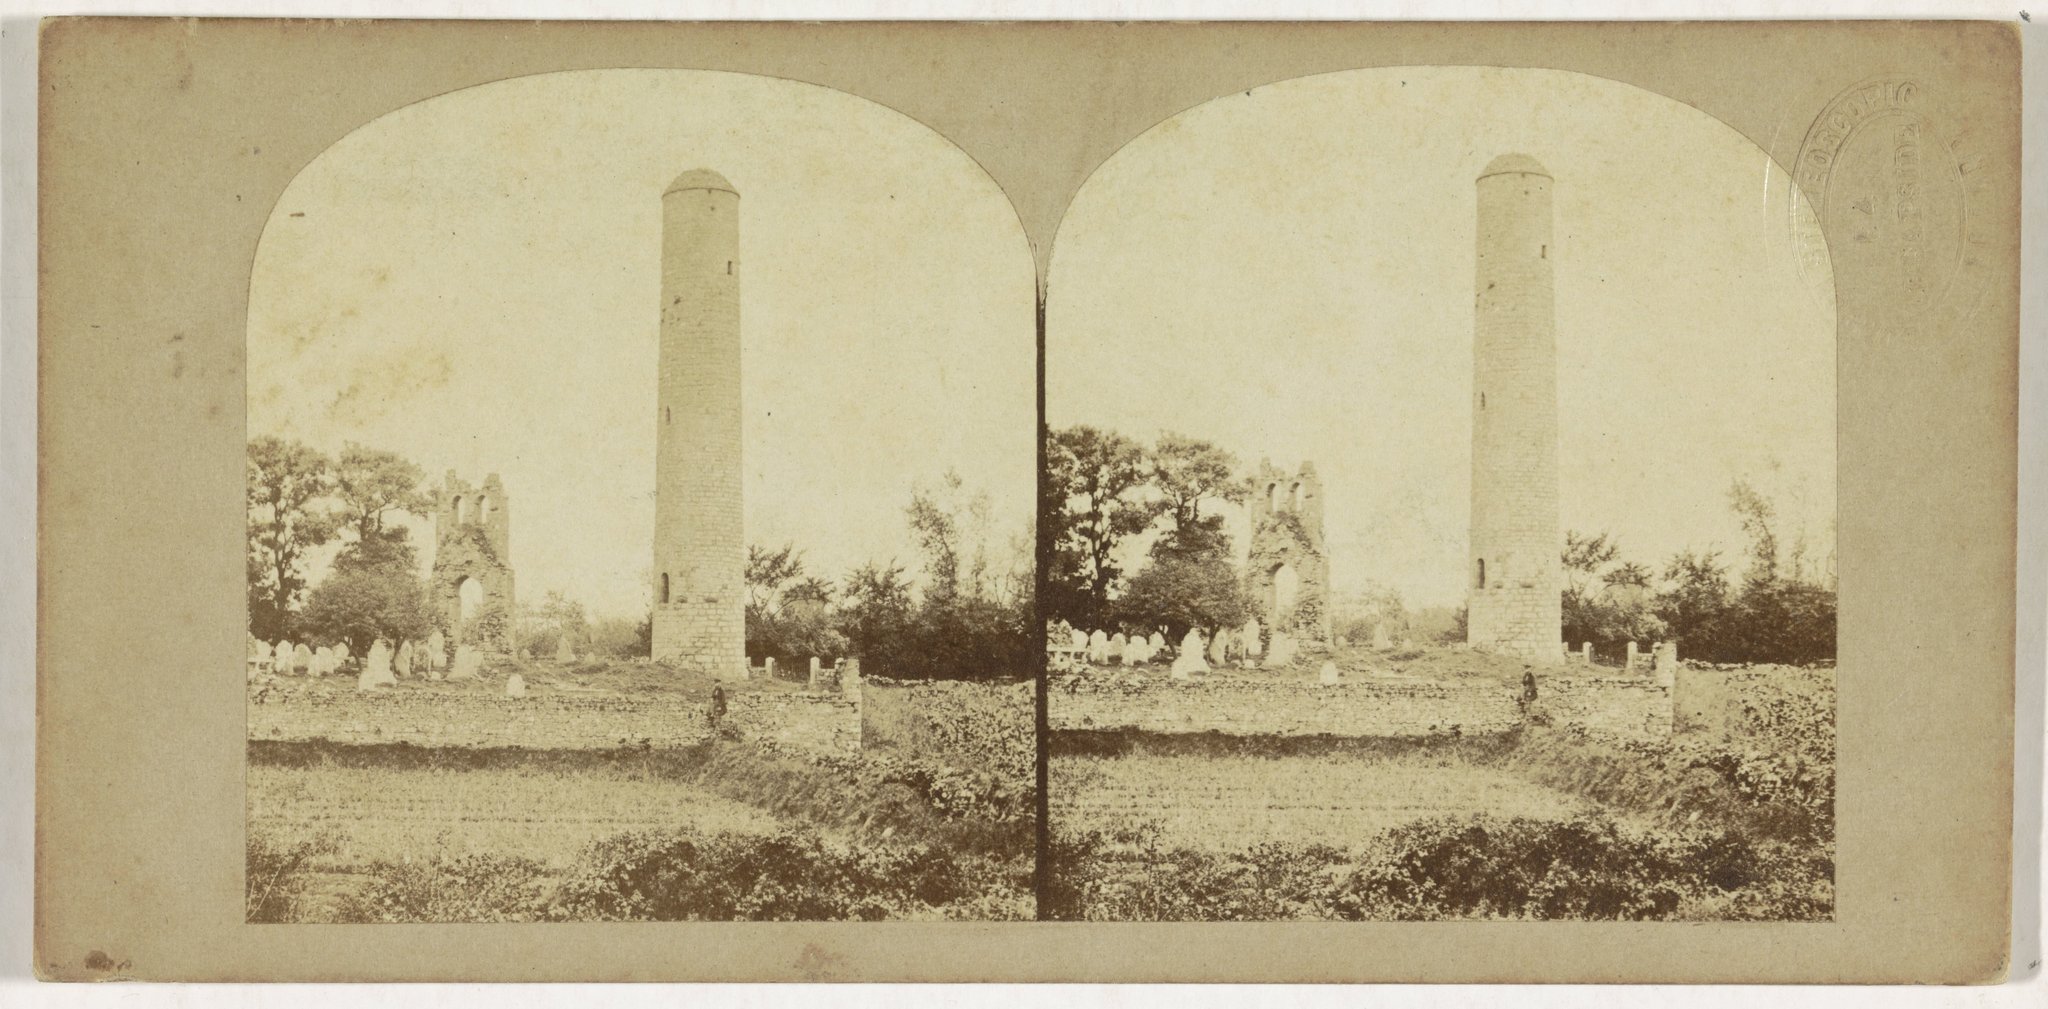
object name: stereograph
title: Ronde toren bij Donaghmore, graafschap Meath, Ierland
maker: Anonymous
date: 1856-1922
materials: cardboard, paper, photographic support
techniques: albumen print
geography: london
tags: ierland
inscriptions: name: ‘H. Ameschot.’, inscription: ‘N.° 8.’, check stamp: ‘London Stereoscopic Company / 54 Cheapside’, label: ‘Round Tower at Donaghmore, County Meath, Ireland.’